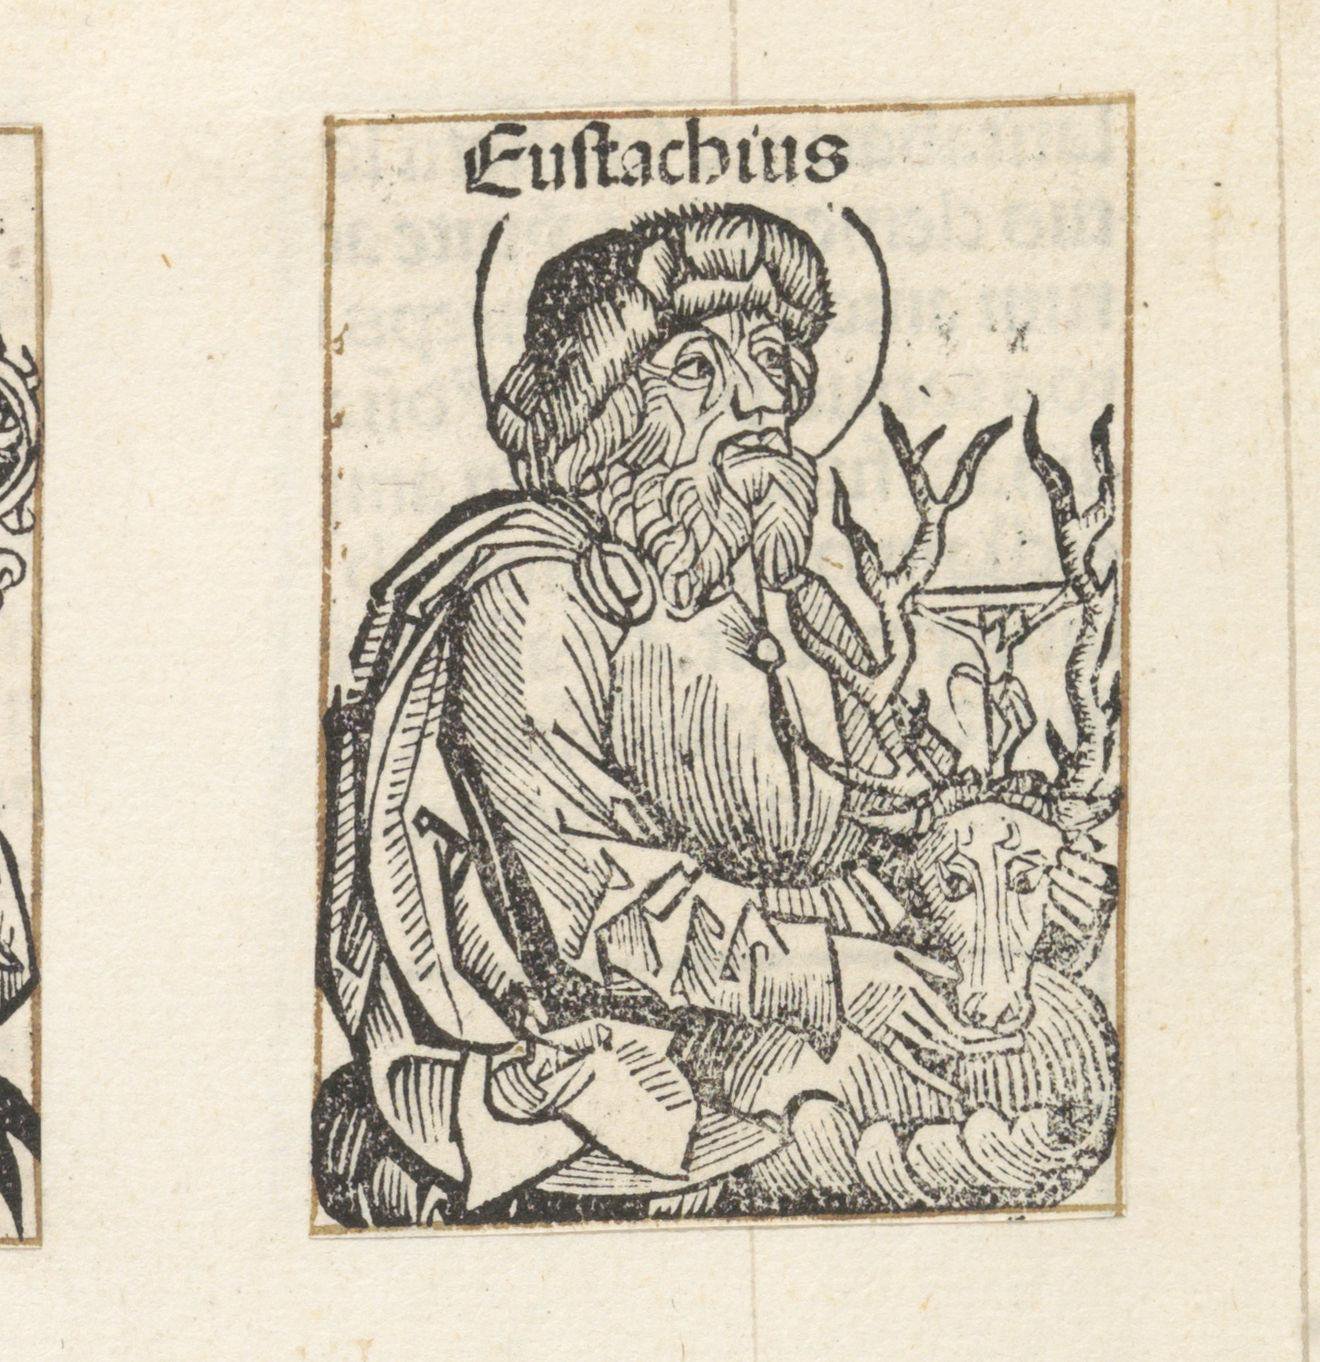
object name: album leaf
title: Eustachius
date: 1493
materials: paper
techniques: letterpress printing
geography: nuremberg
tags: the roman soldier and hunter eustace (eustachius, eustathius); possible attributes: banner, bull of brass, cuirass, hunting horn, lance, stag's head with crucifix, sword, two sons, wife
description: De houtsnede wordt gebruikt als boekillustratie in de Liber Chronicarum (of Neurenbergkroniek) van Hartmann Schedel, verschenen in het Latijn en Duits in 1493. Zie de Latijnse uitgave, folio 110r.